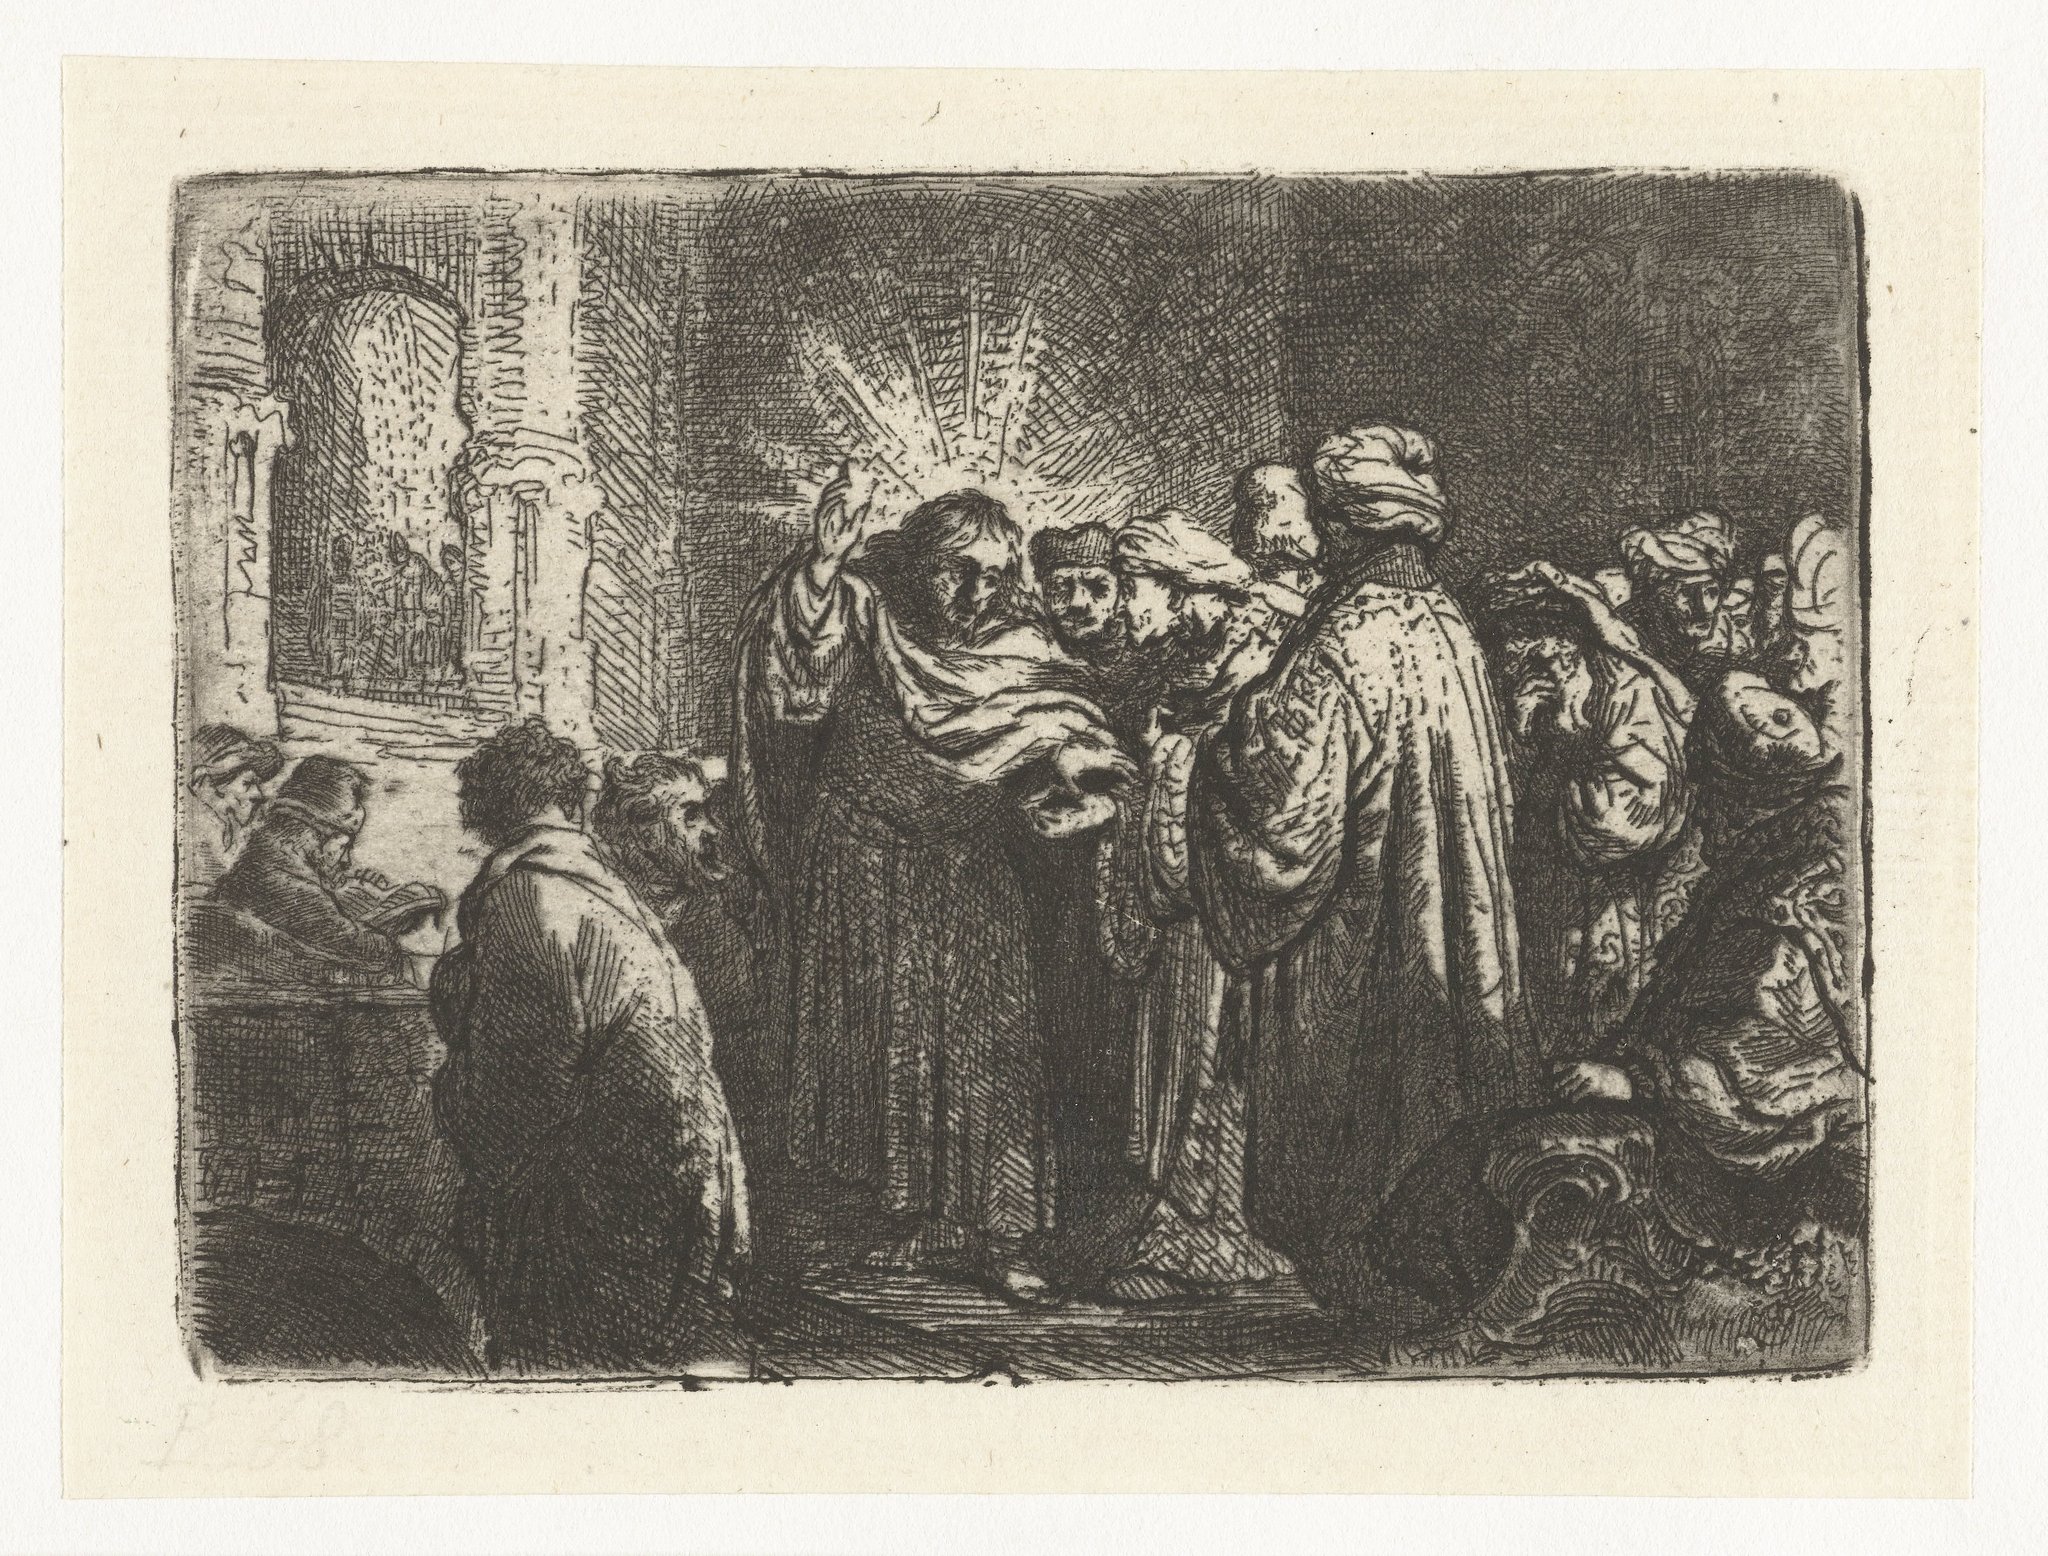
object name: print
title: The tribute money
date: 1850-1906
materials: paper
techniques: drypoint, etching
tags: christ discussing the temple tribute with the apostles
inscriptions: inscription: ‘Coppier’